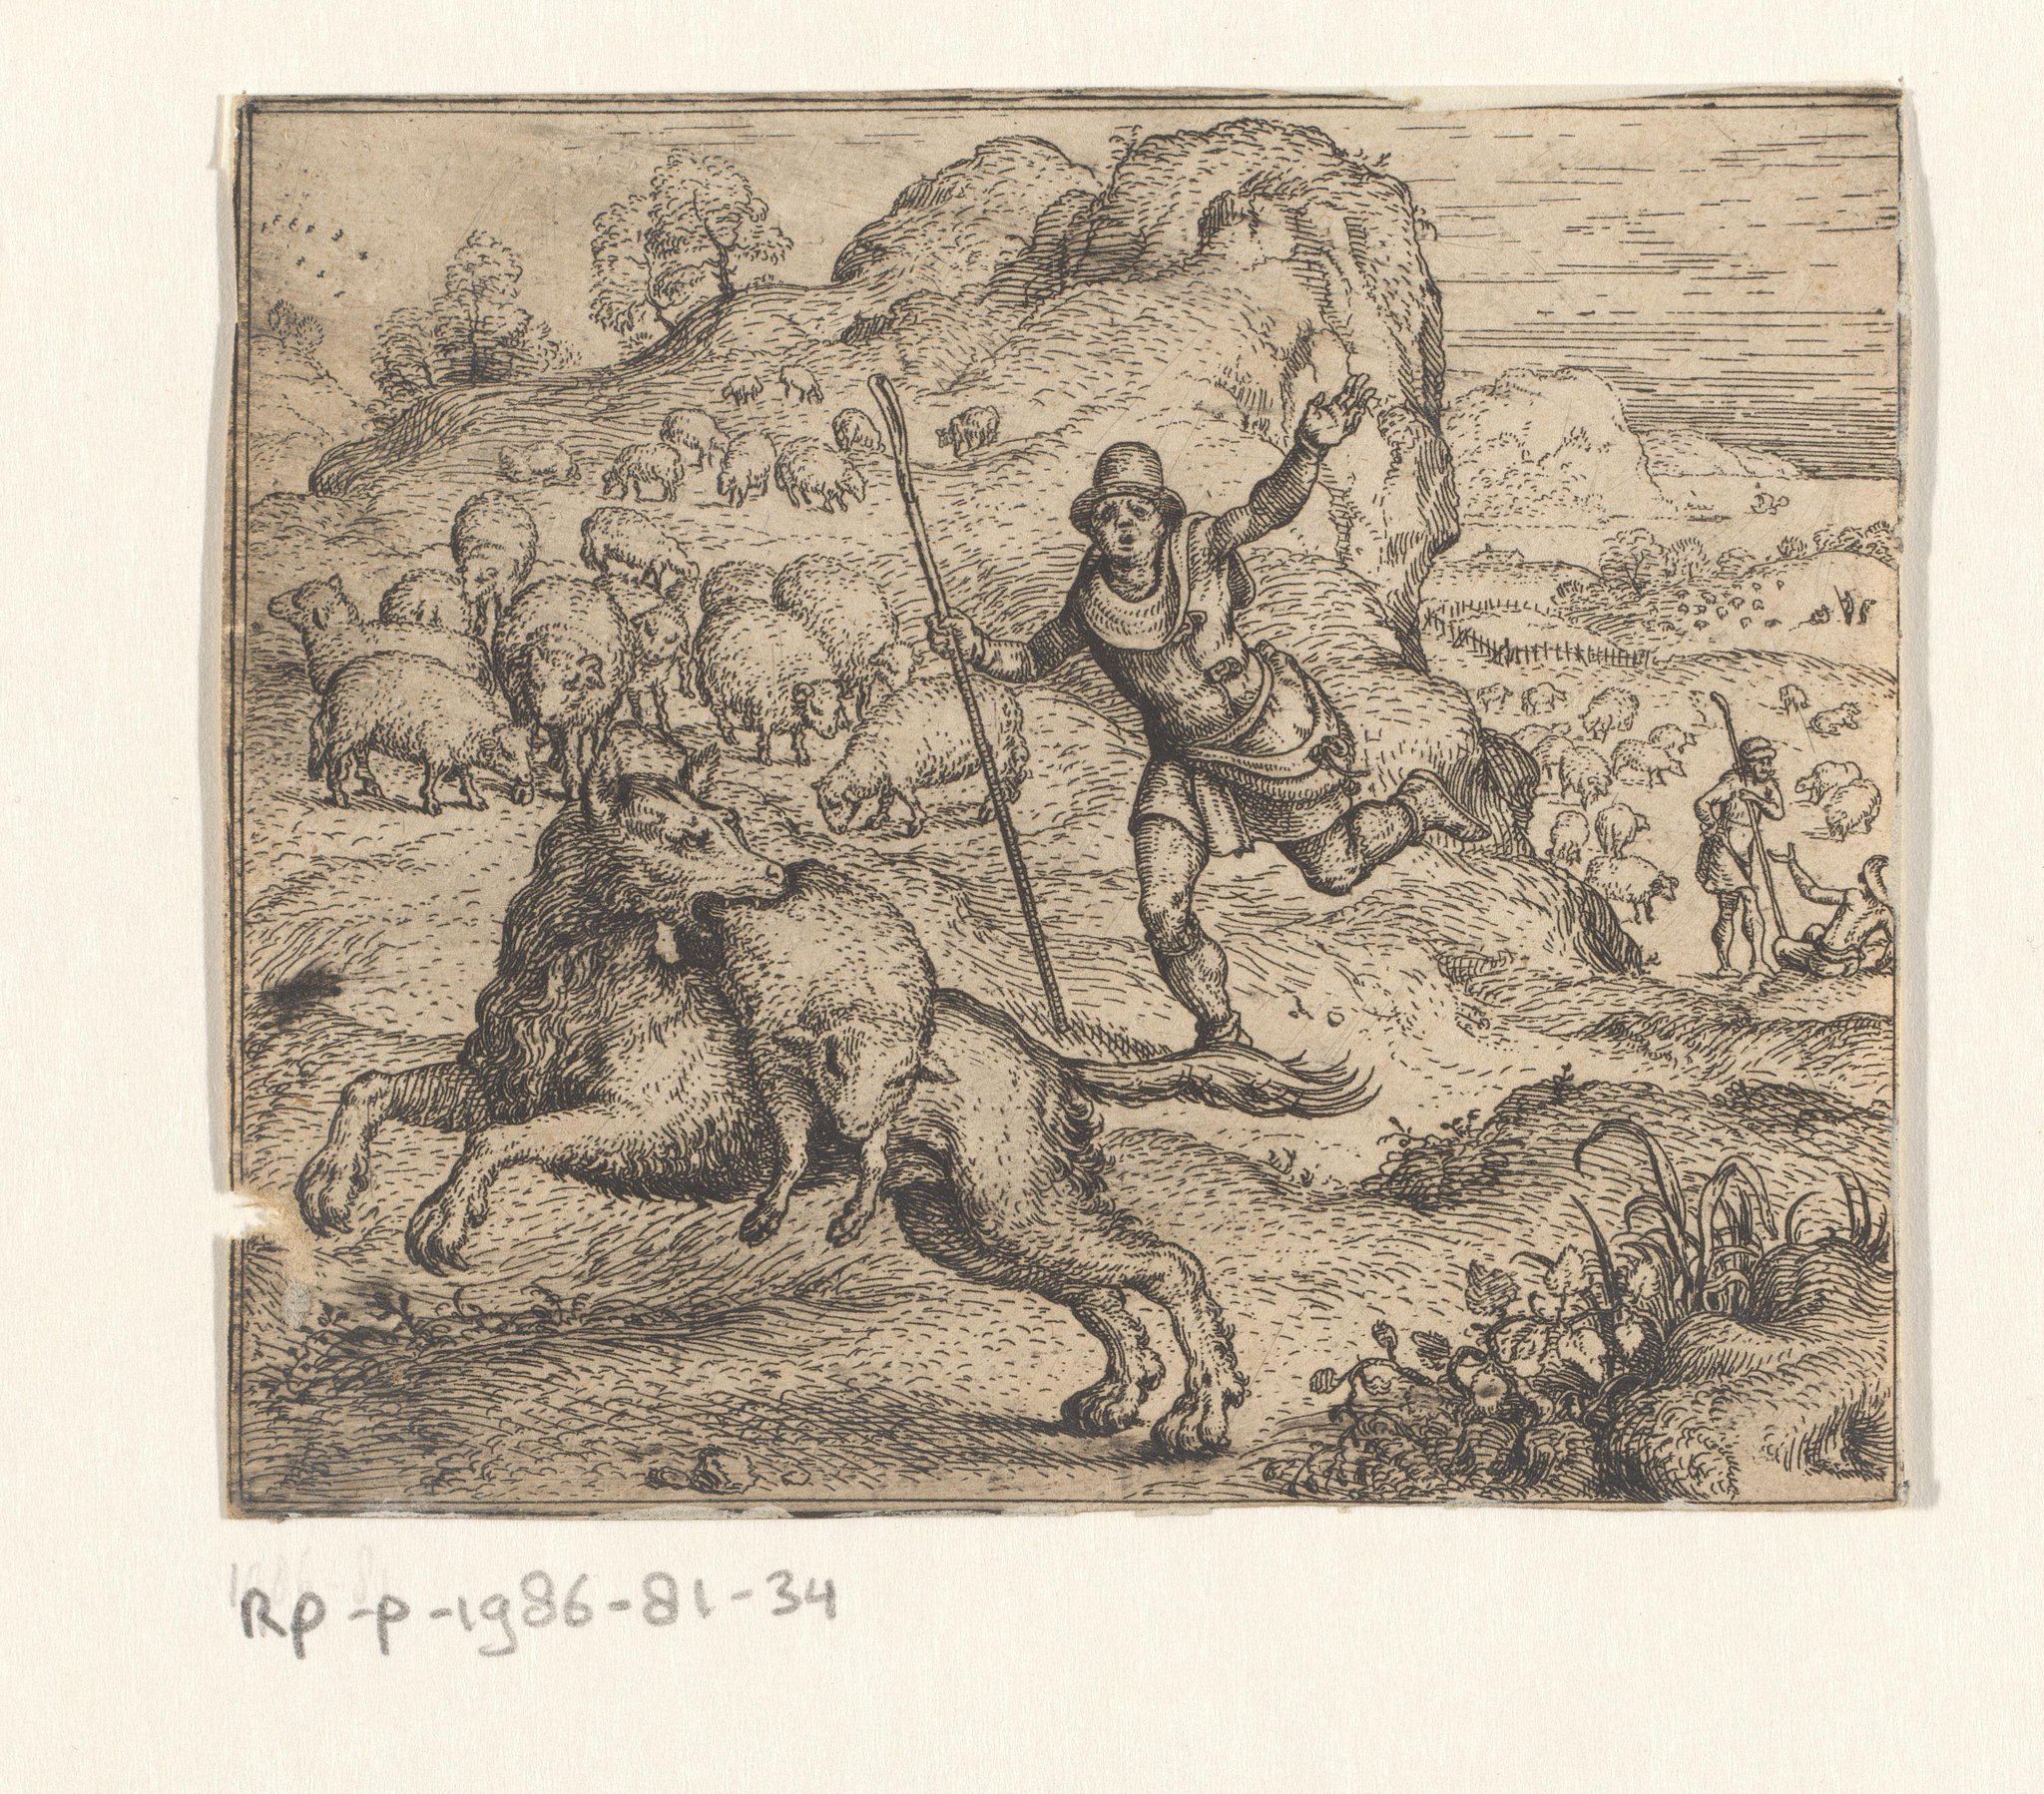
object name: print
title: Fabel van de jongen die wolf riep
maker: marcus gheeraerts (i)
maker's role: draughtsman, painter, print maker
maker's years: 1520-1590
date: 1567-1617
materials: paper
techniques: etching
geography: bruges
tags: herding, herdsman, herdswoman, shepherd, shepherdess, cowherd, etc., fables of aesop : use 85(...), sheep, herd, flock, beasts of prey, predatory animals: wolf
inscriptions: collector's mark: Lugt 2228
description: De prent is met tekst op verso gebruikt in: Dene, Eduard de. De warachtighe fabulen der dieren. Brugge: Pieter de Clerck, 1567. De prent is vermoedelijk daarna nog gebruikt in andere publicaties uit 1579 en 1617. Zie Hollstein. Mogelijk is deze prent ook nog gebruikt in 'Vorstelijcke warande der dieren', 1682.